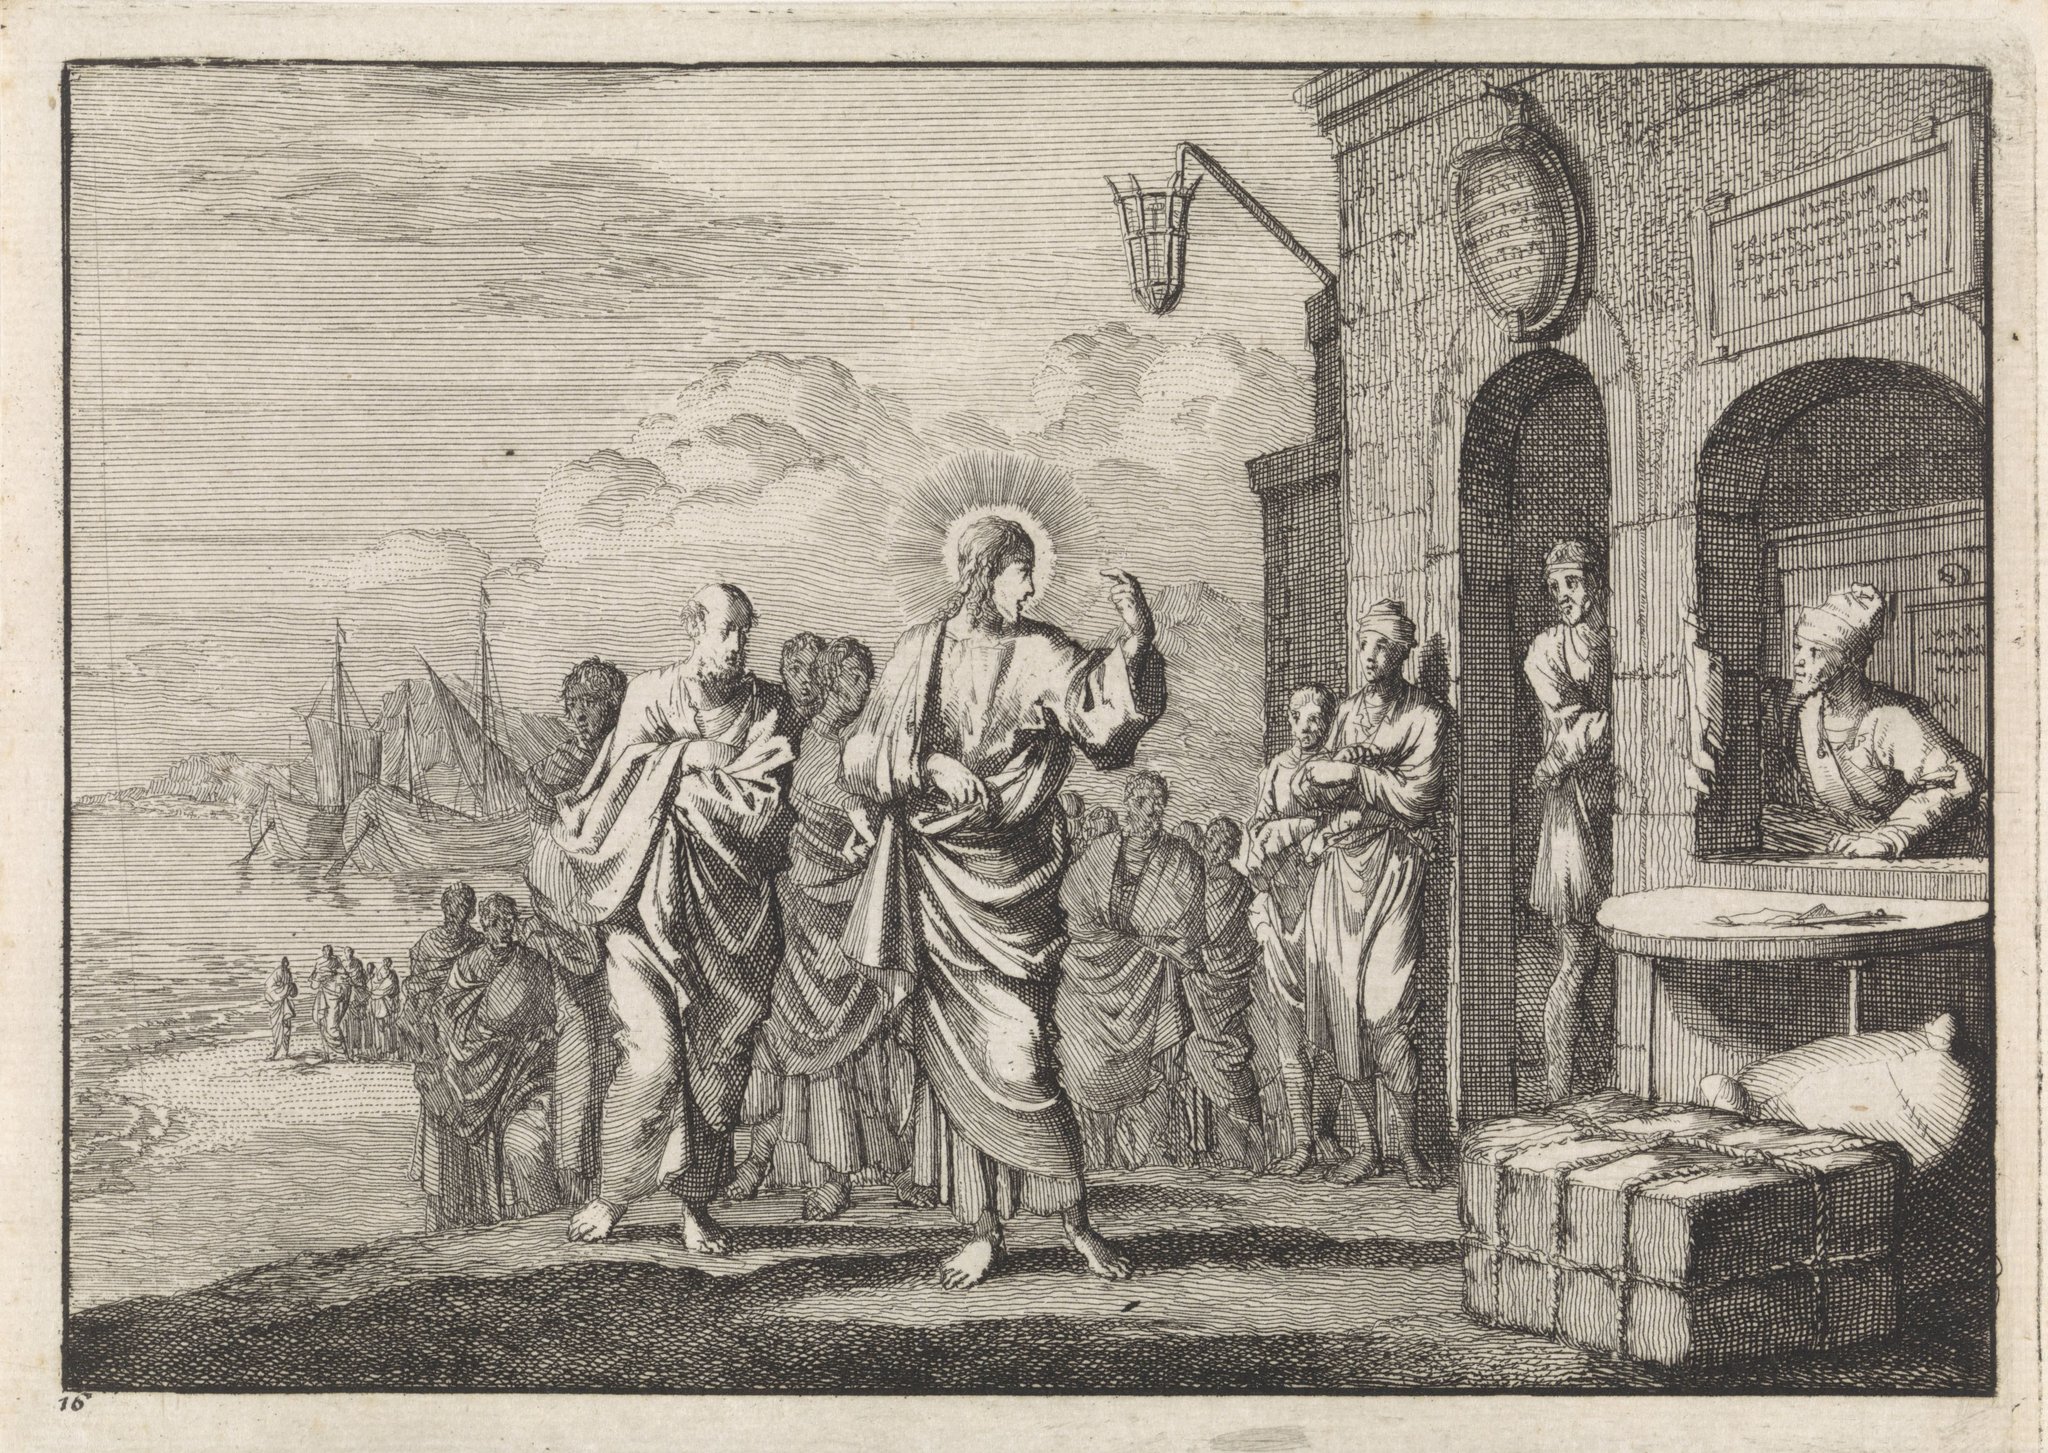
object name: print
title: Roeping van Matteüs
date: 1703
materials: paper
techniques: etching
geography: haarlem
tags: calling of matthew (levi), the tax-collector (usually with money lying on the table and people paying taxes) (matthew 9:9; mark 2:14; luke 5:27-28)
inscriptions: collector's mark: Lugt 2228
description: Proefdruk van een boekillustratie voor David Martin. Historie des Ouden en Nieuwen Testaments. Amsterdam, Pieter Mortier, 1703. Deel II. De boekillustraties voor de Mortierbijbel hebben verschillende staten en kopieën, waarbij de chronologische volgorde moeilijk te achterhalen valt. Als boekillustraties werden ze bovendien herhaaldelijk opnieuw gebruikt voor andere boekwerken.